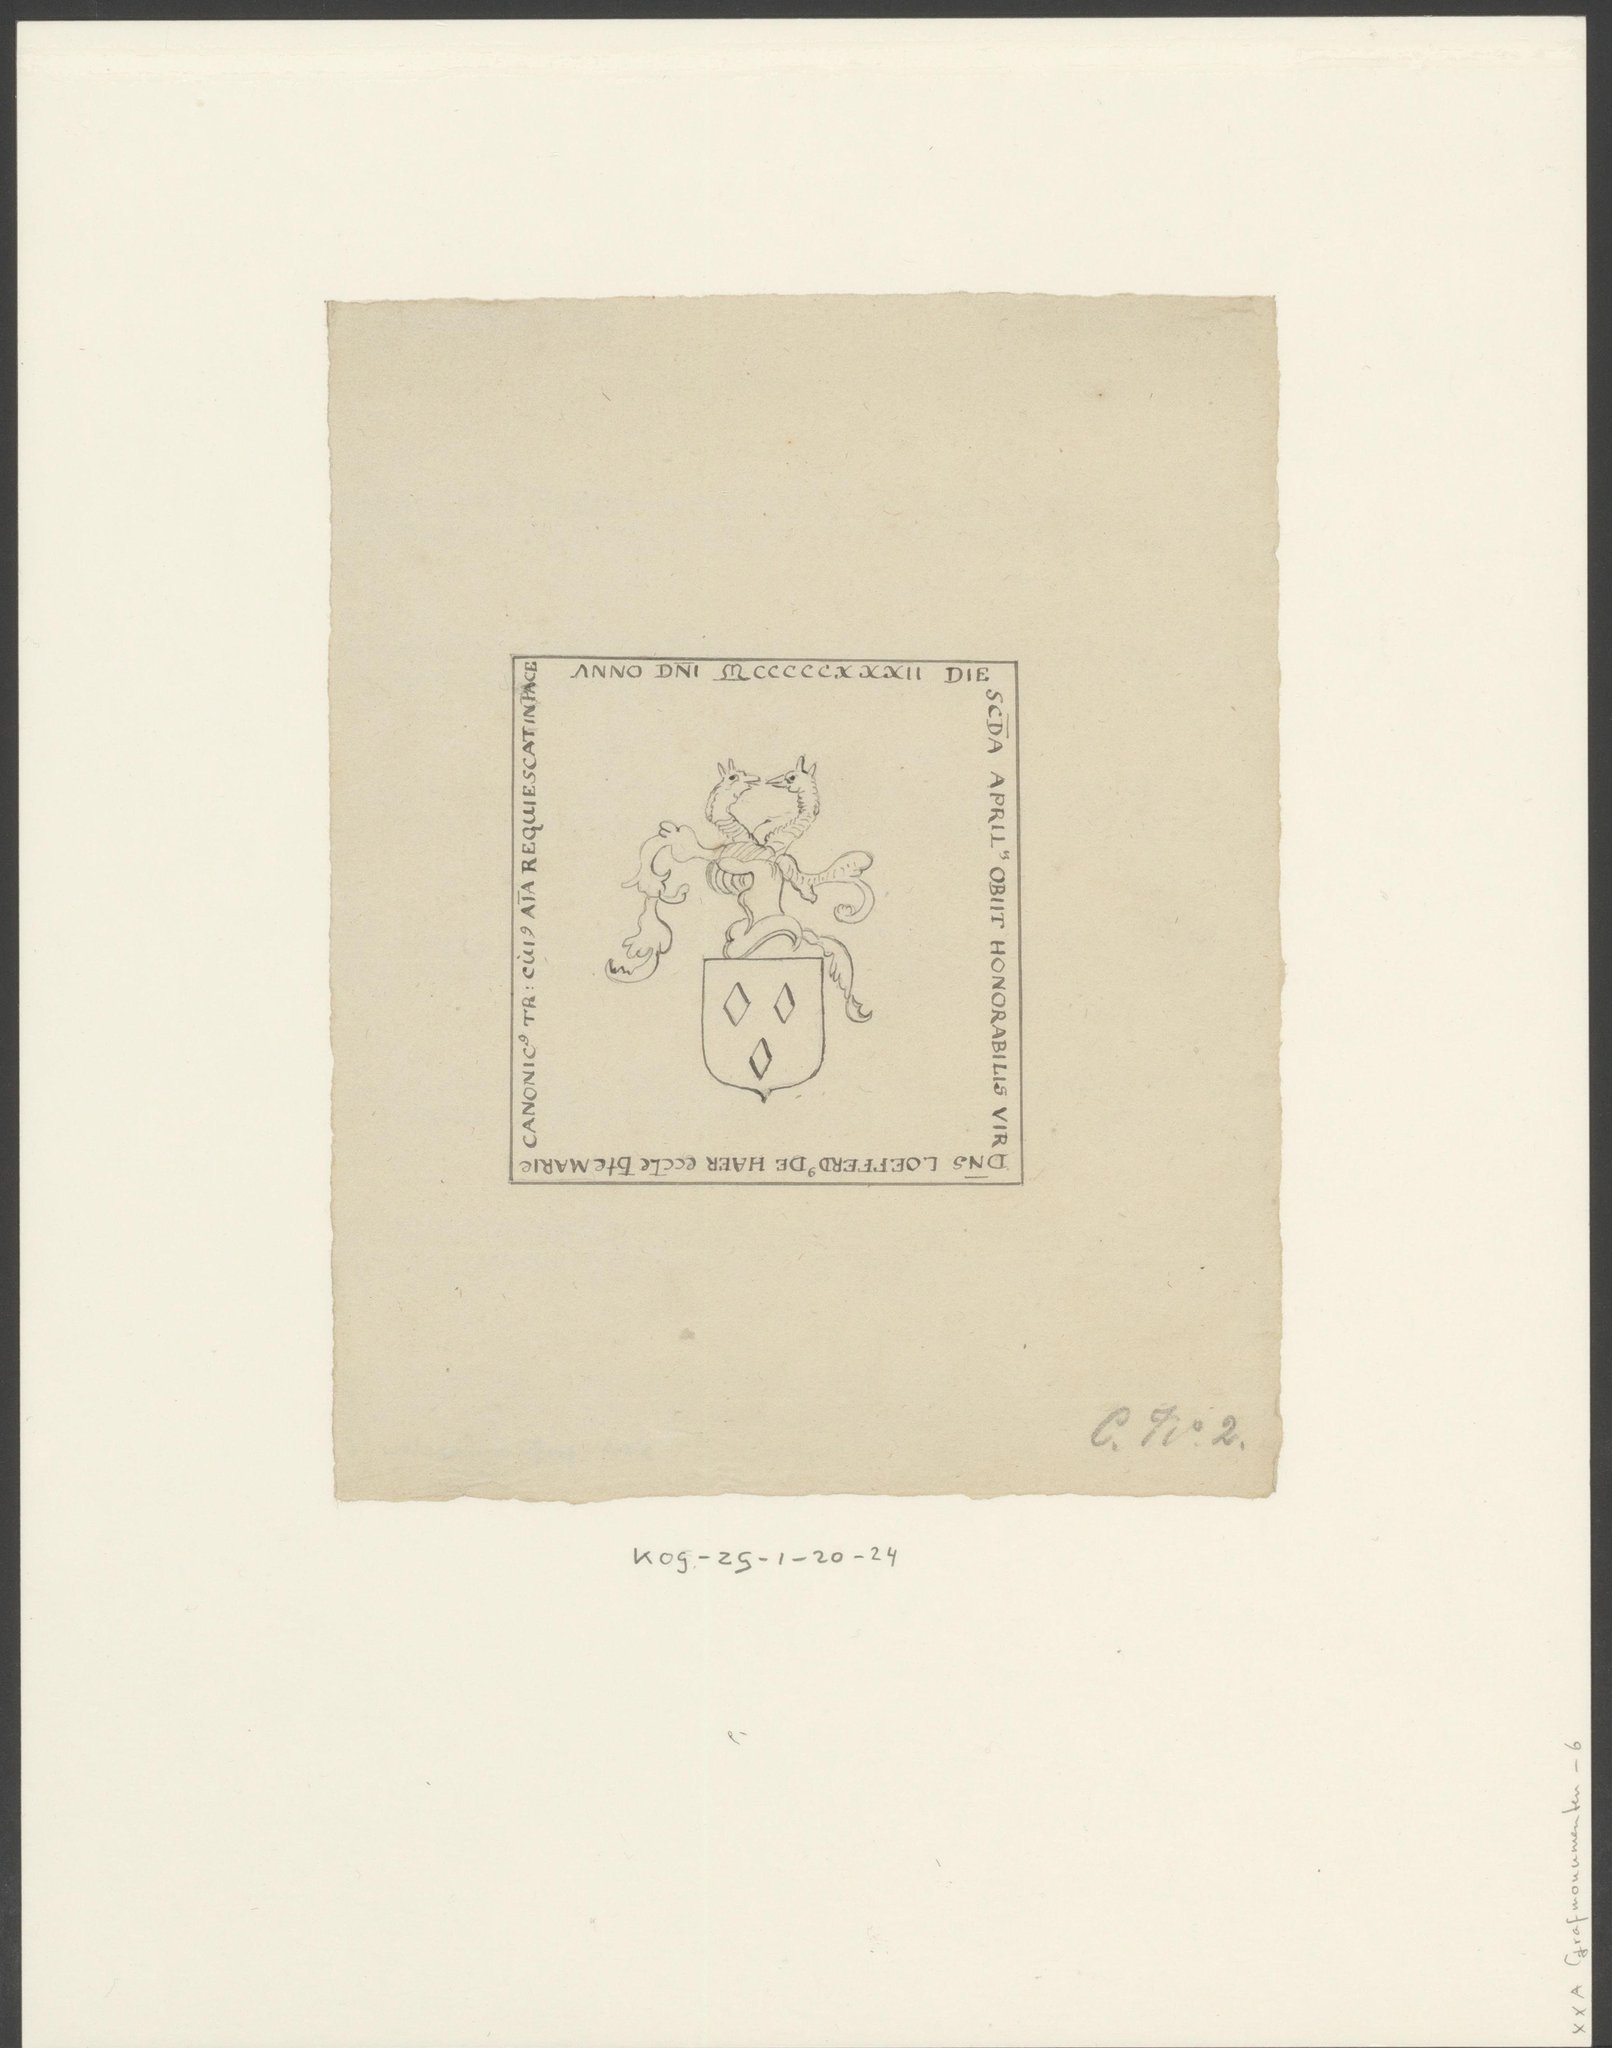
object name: drawing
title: Grafmonument het wapen van de kanunnik Loefferd te Utrecht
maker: Anonymous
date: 1800-1899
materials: ink, paper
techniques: pen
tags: gravestone, tombstone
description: Onderwerpsrubrieken binnen de Atlas Zeden en Gewoonten: Zeden en Gewoonten in Engeren Zin, Des menschen beging, midden en einde, Grafmonumenten.